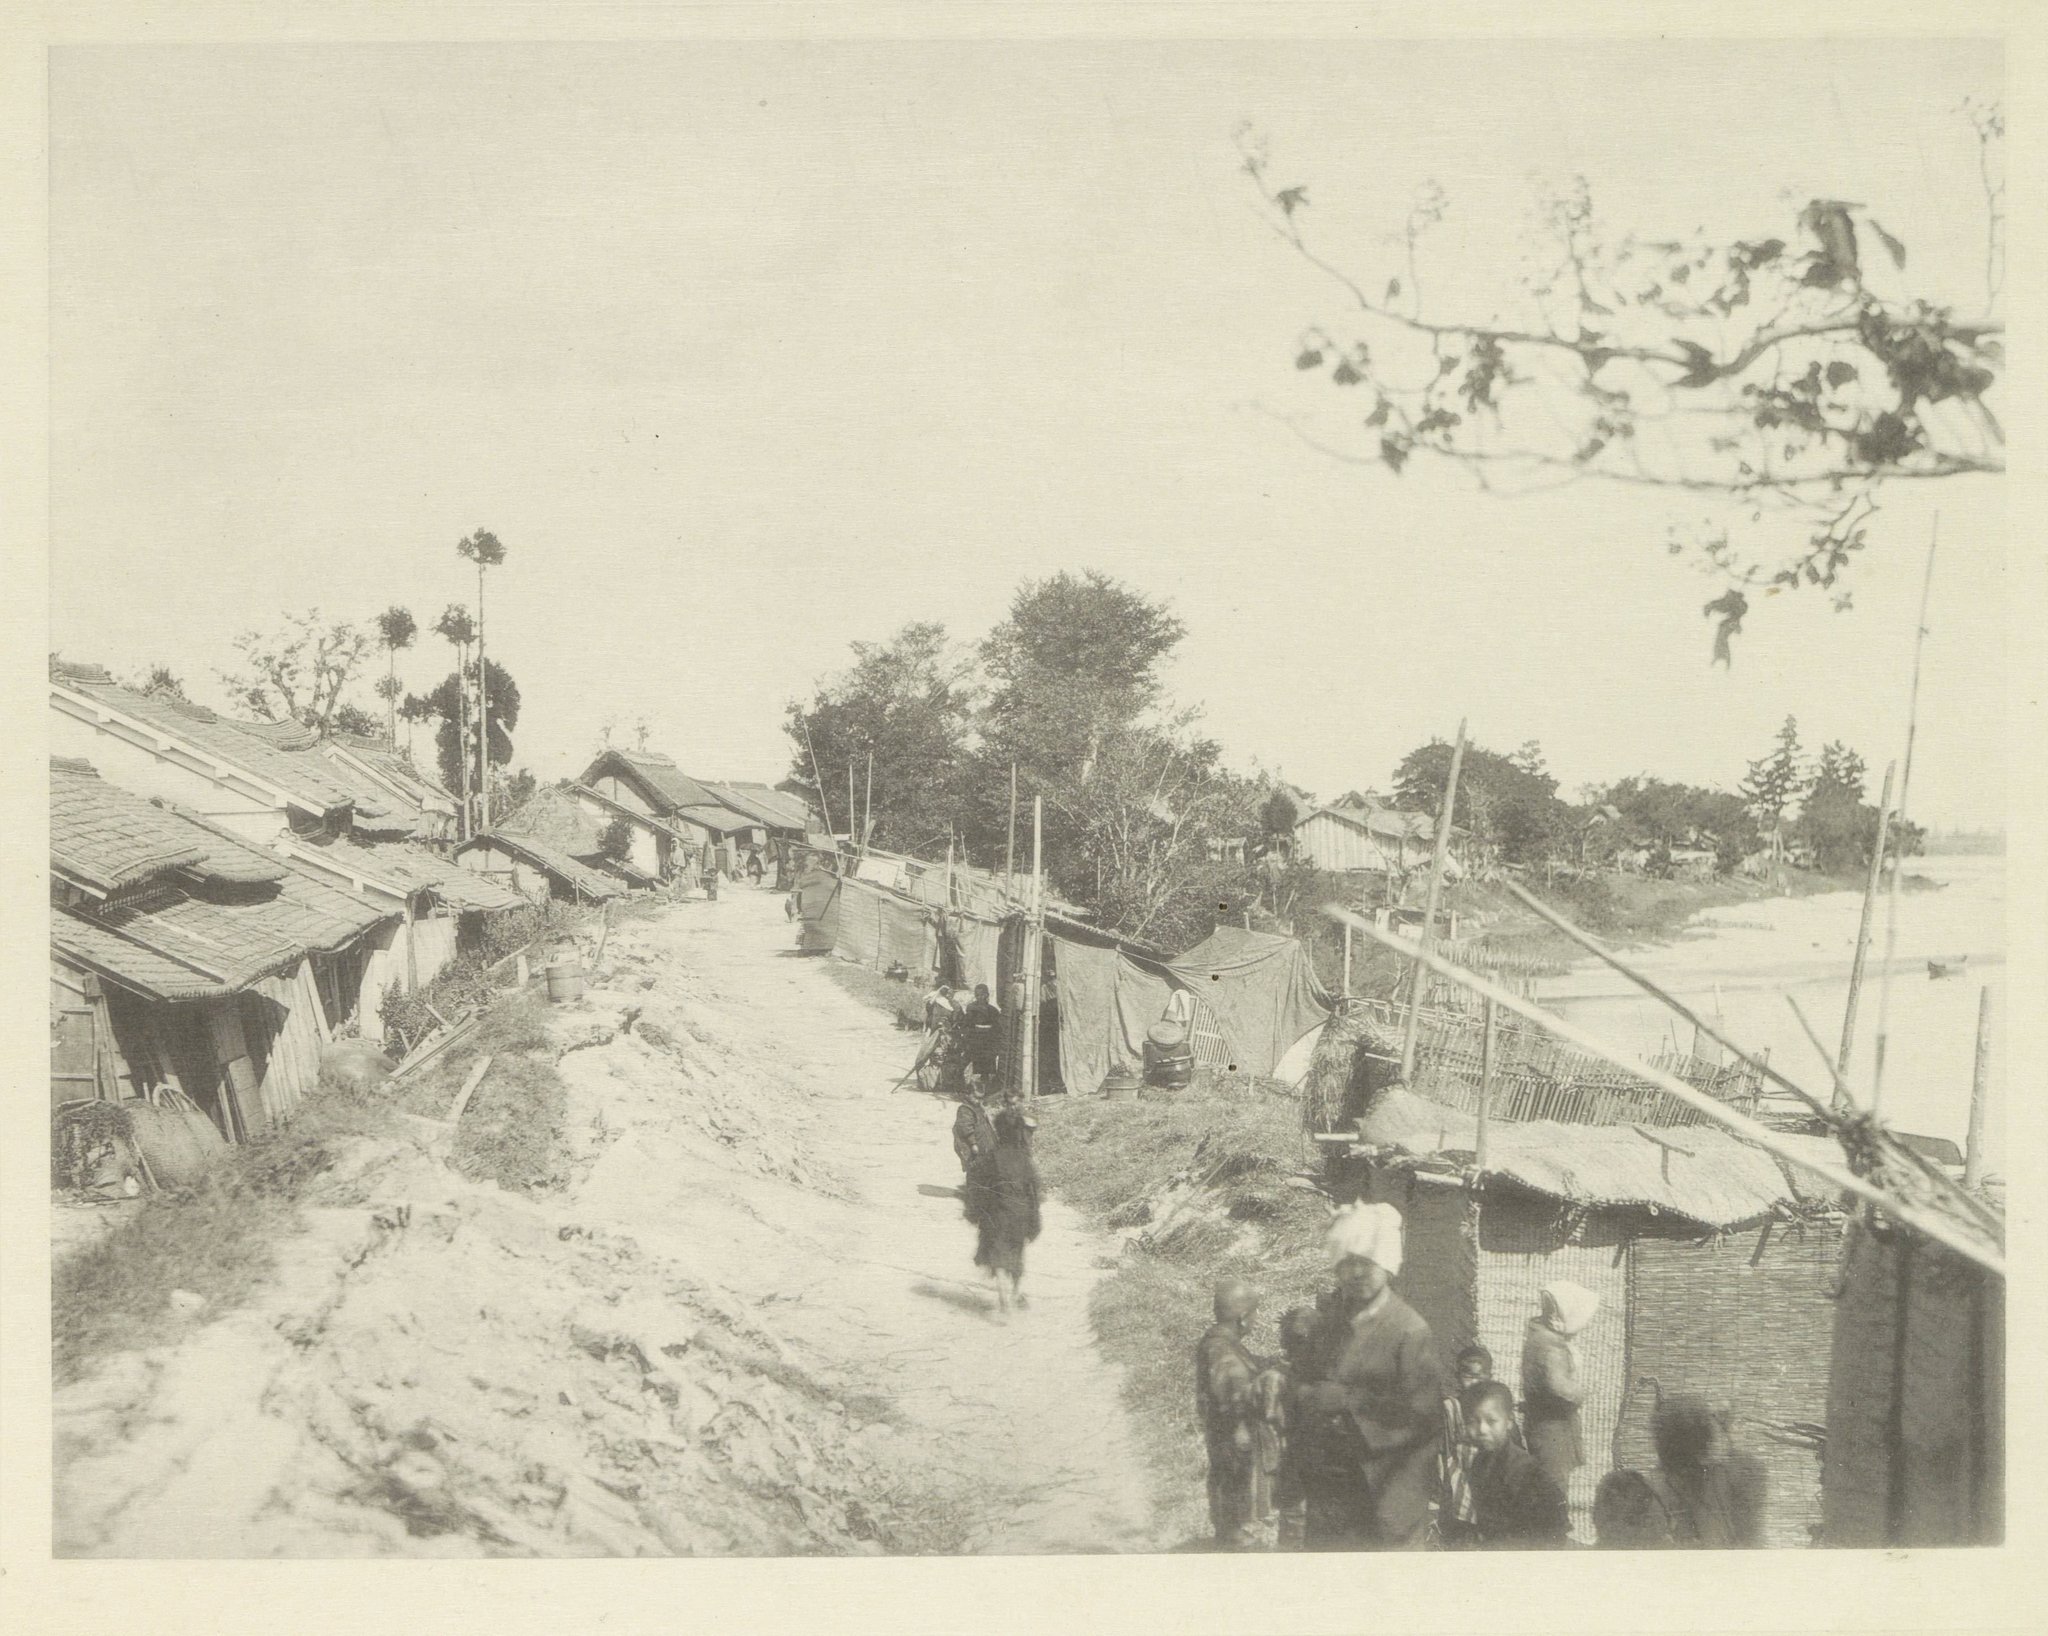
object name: photomechanical print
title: Tijdelijke woningen langs de Biwajima-rivier te Japan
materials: paper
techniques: photograph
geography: japan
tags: consequences of an earthquake, housing, ruin of a dwelling, house, castle, etc.